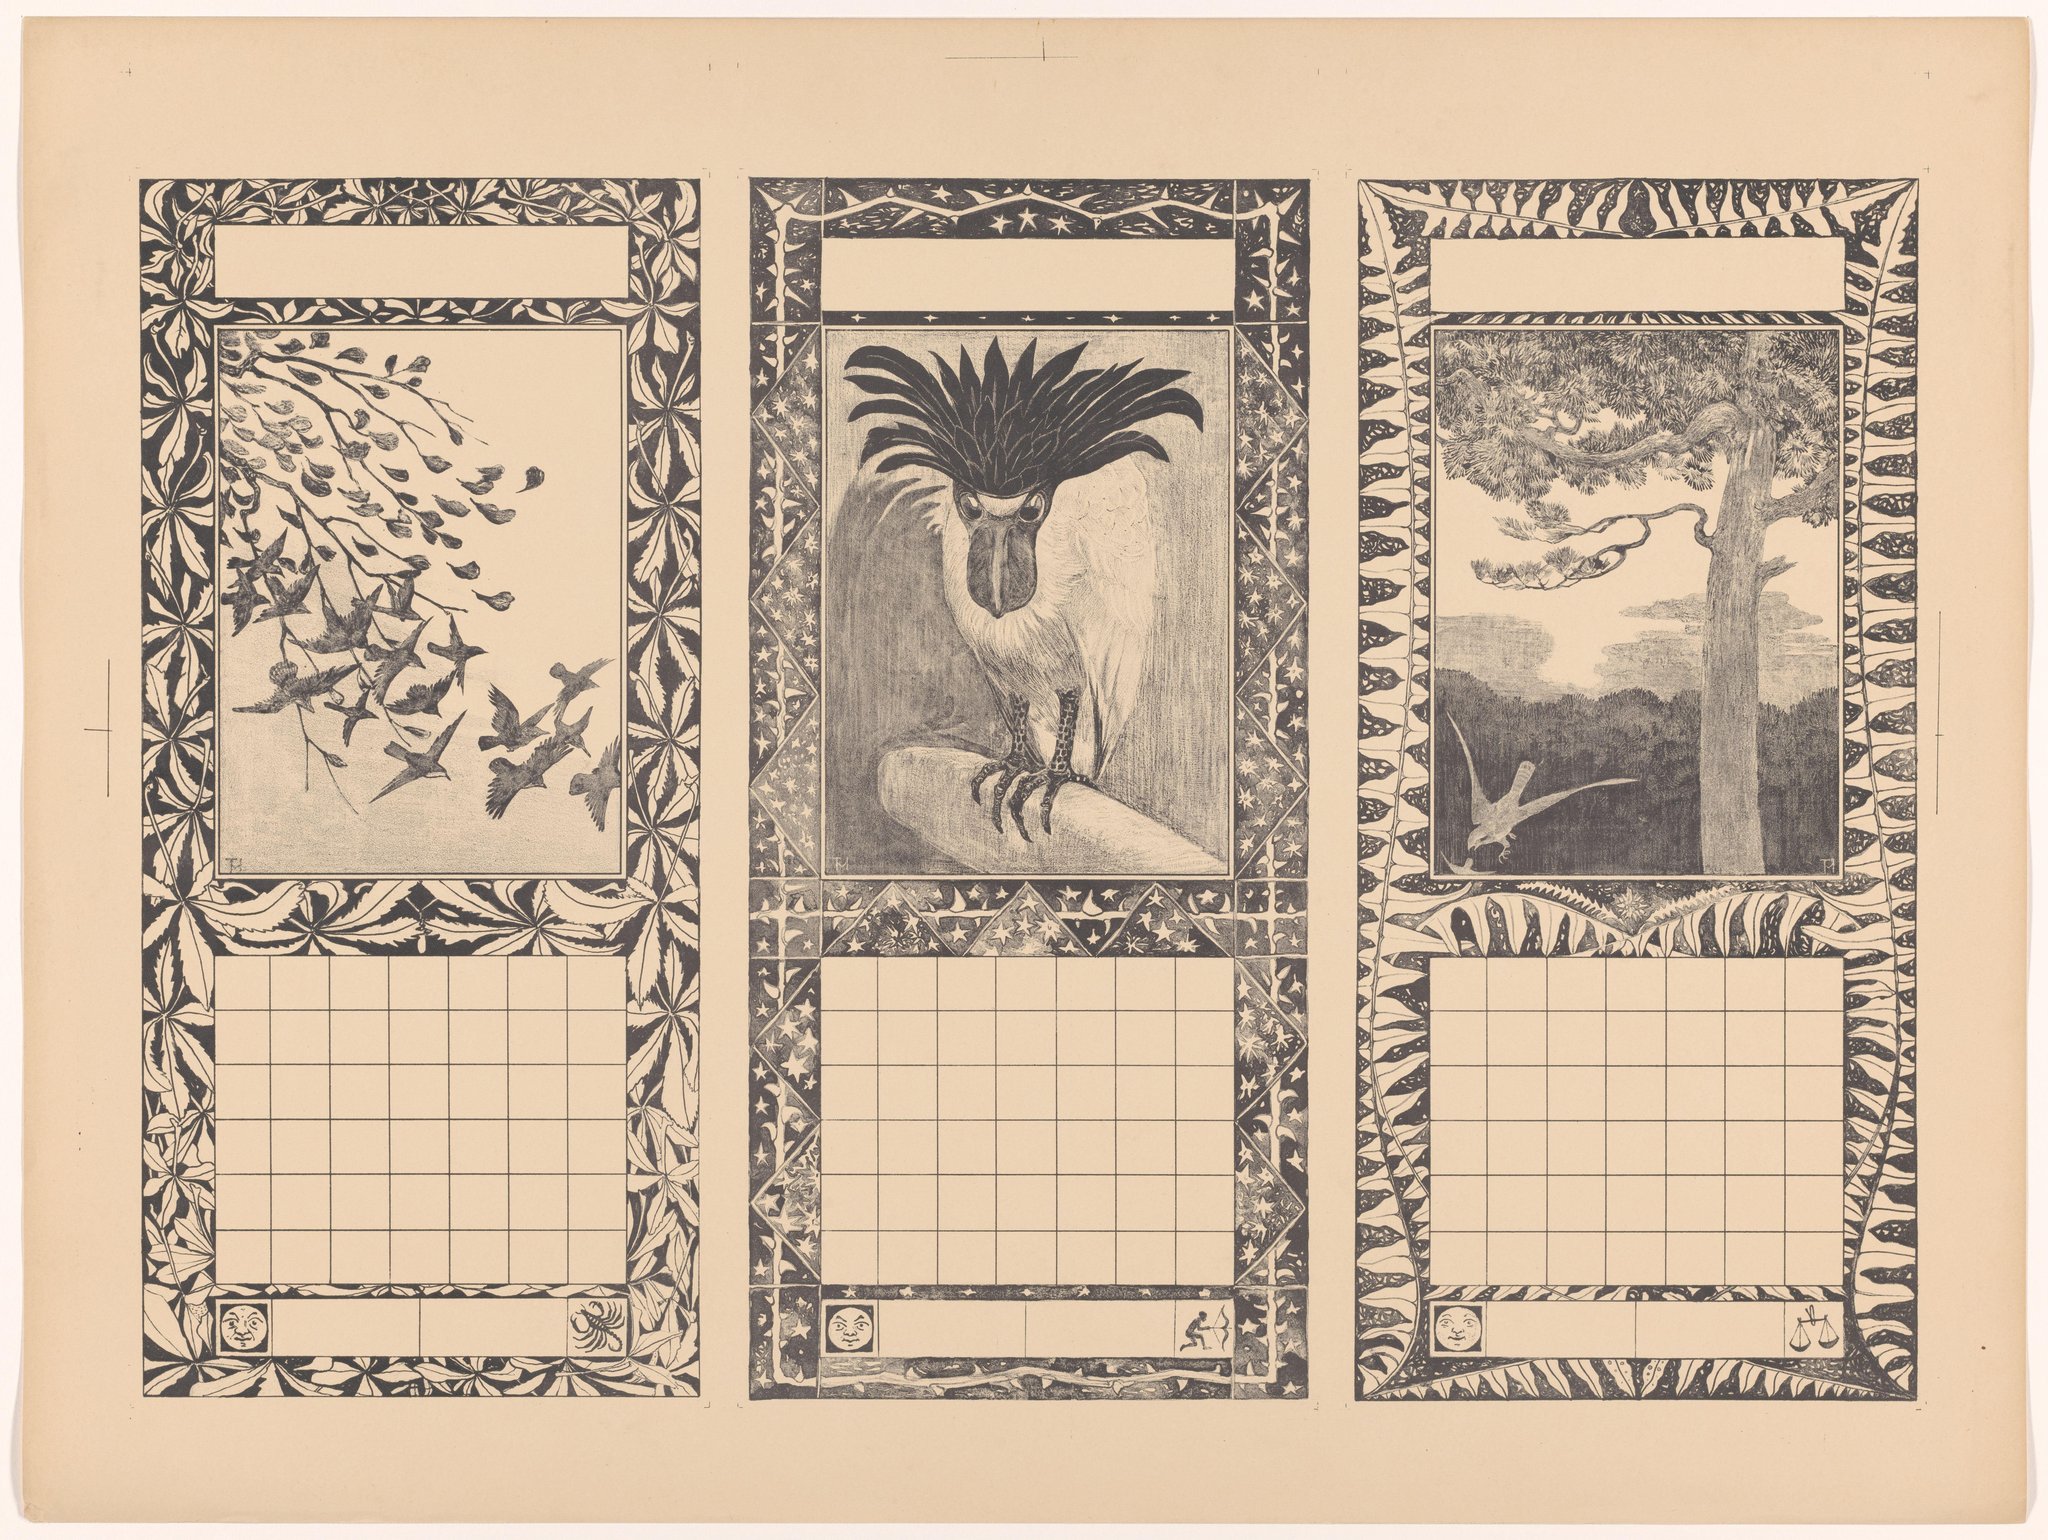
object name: print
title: Kalenders voor oktober, november en september 1904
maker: theo van hoytema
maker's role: draughtsman, painter, print maker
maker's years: 1863-1917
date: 1904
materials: paper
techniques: lithograph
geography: amsterdam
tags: predatory birds: falcon, calendar, almanac, shore-birds and wading-birds: heron, groups of birds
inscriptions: collector's mark: Lugt 2233